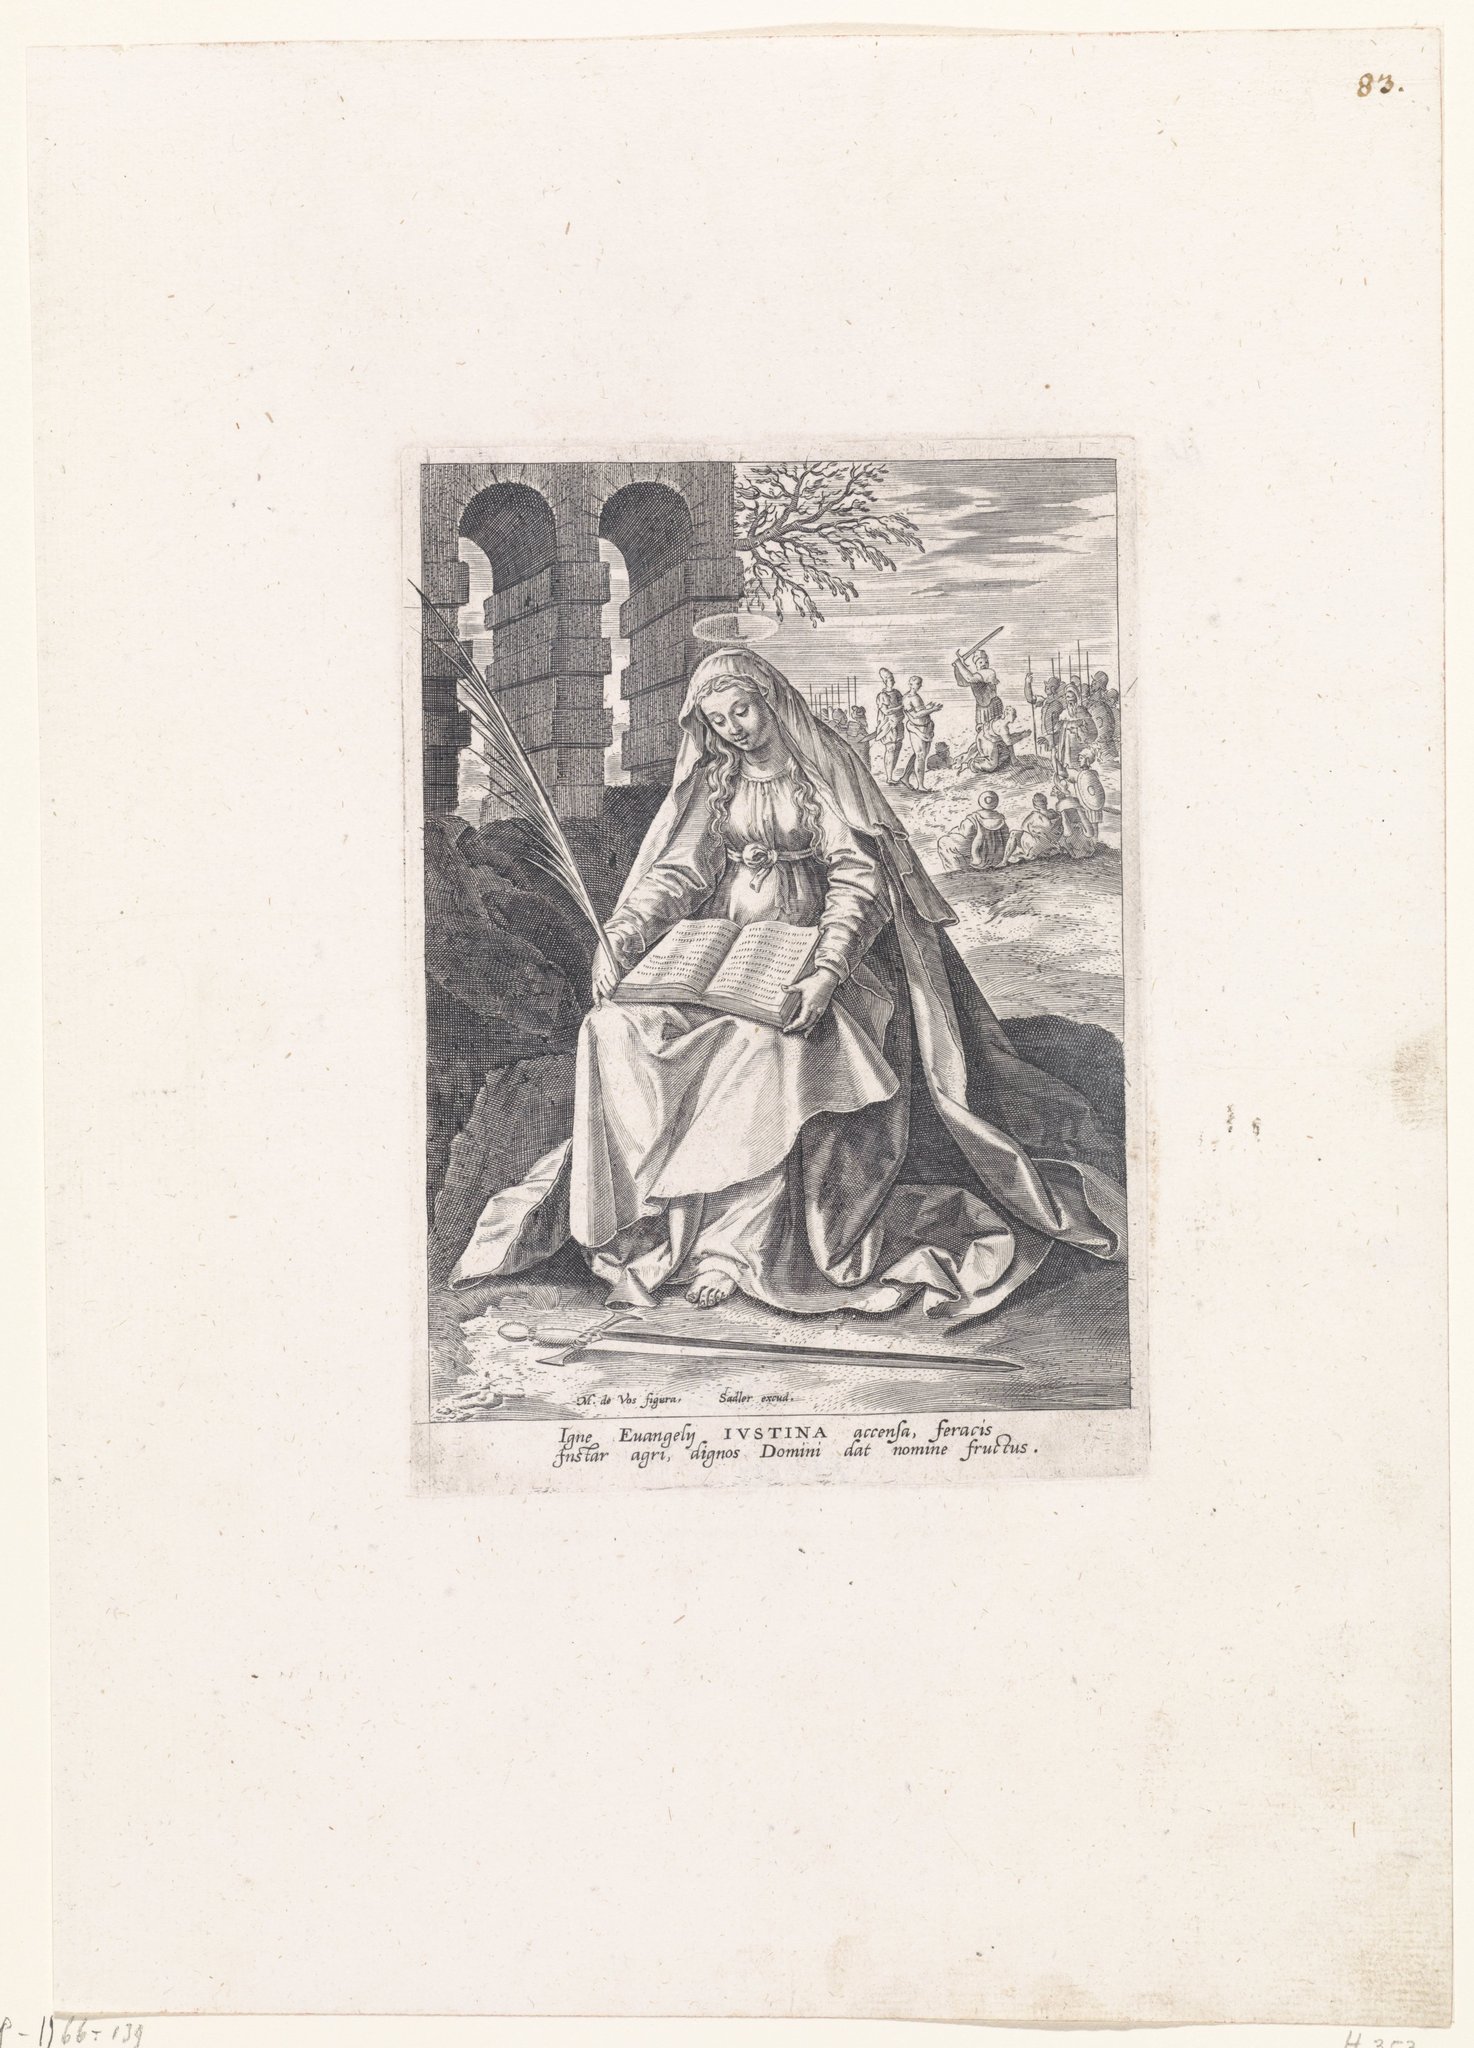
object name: print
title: Spiegel van eerbaarheid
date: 1583-1587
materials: paper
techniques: engraving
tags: female saints (justina)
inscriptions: collector's mark: Lugt 2228, collector's mark: Lugt 2760, number: ‘83’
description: De H. Justina, zittend. Ze leest een boek. Op de voorgrond ligt een zwaard. Op de achtergrond haar onthoofding. De twaalfde prent van een zeventiendelige serie met vrouwelijke heiligen.